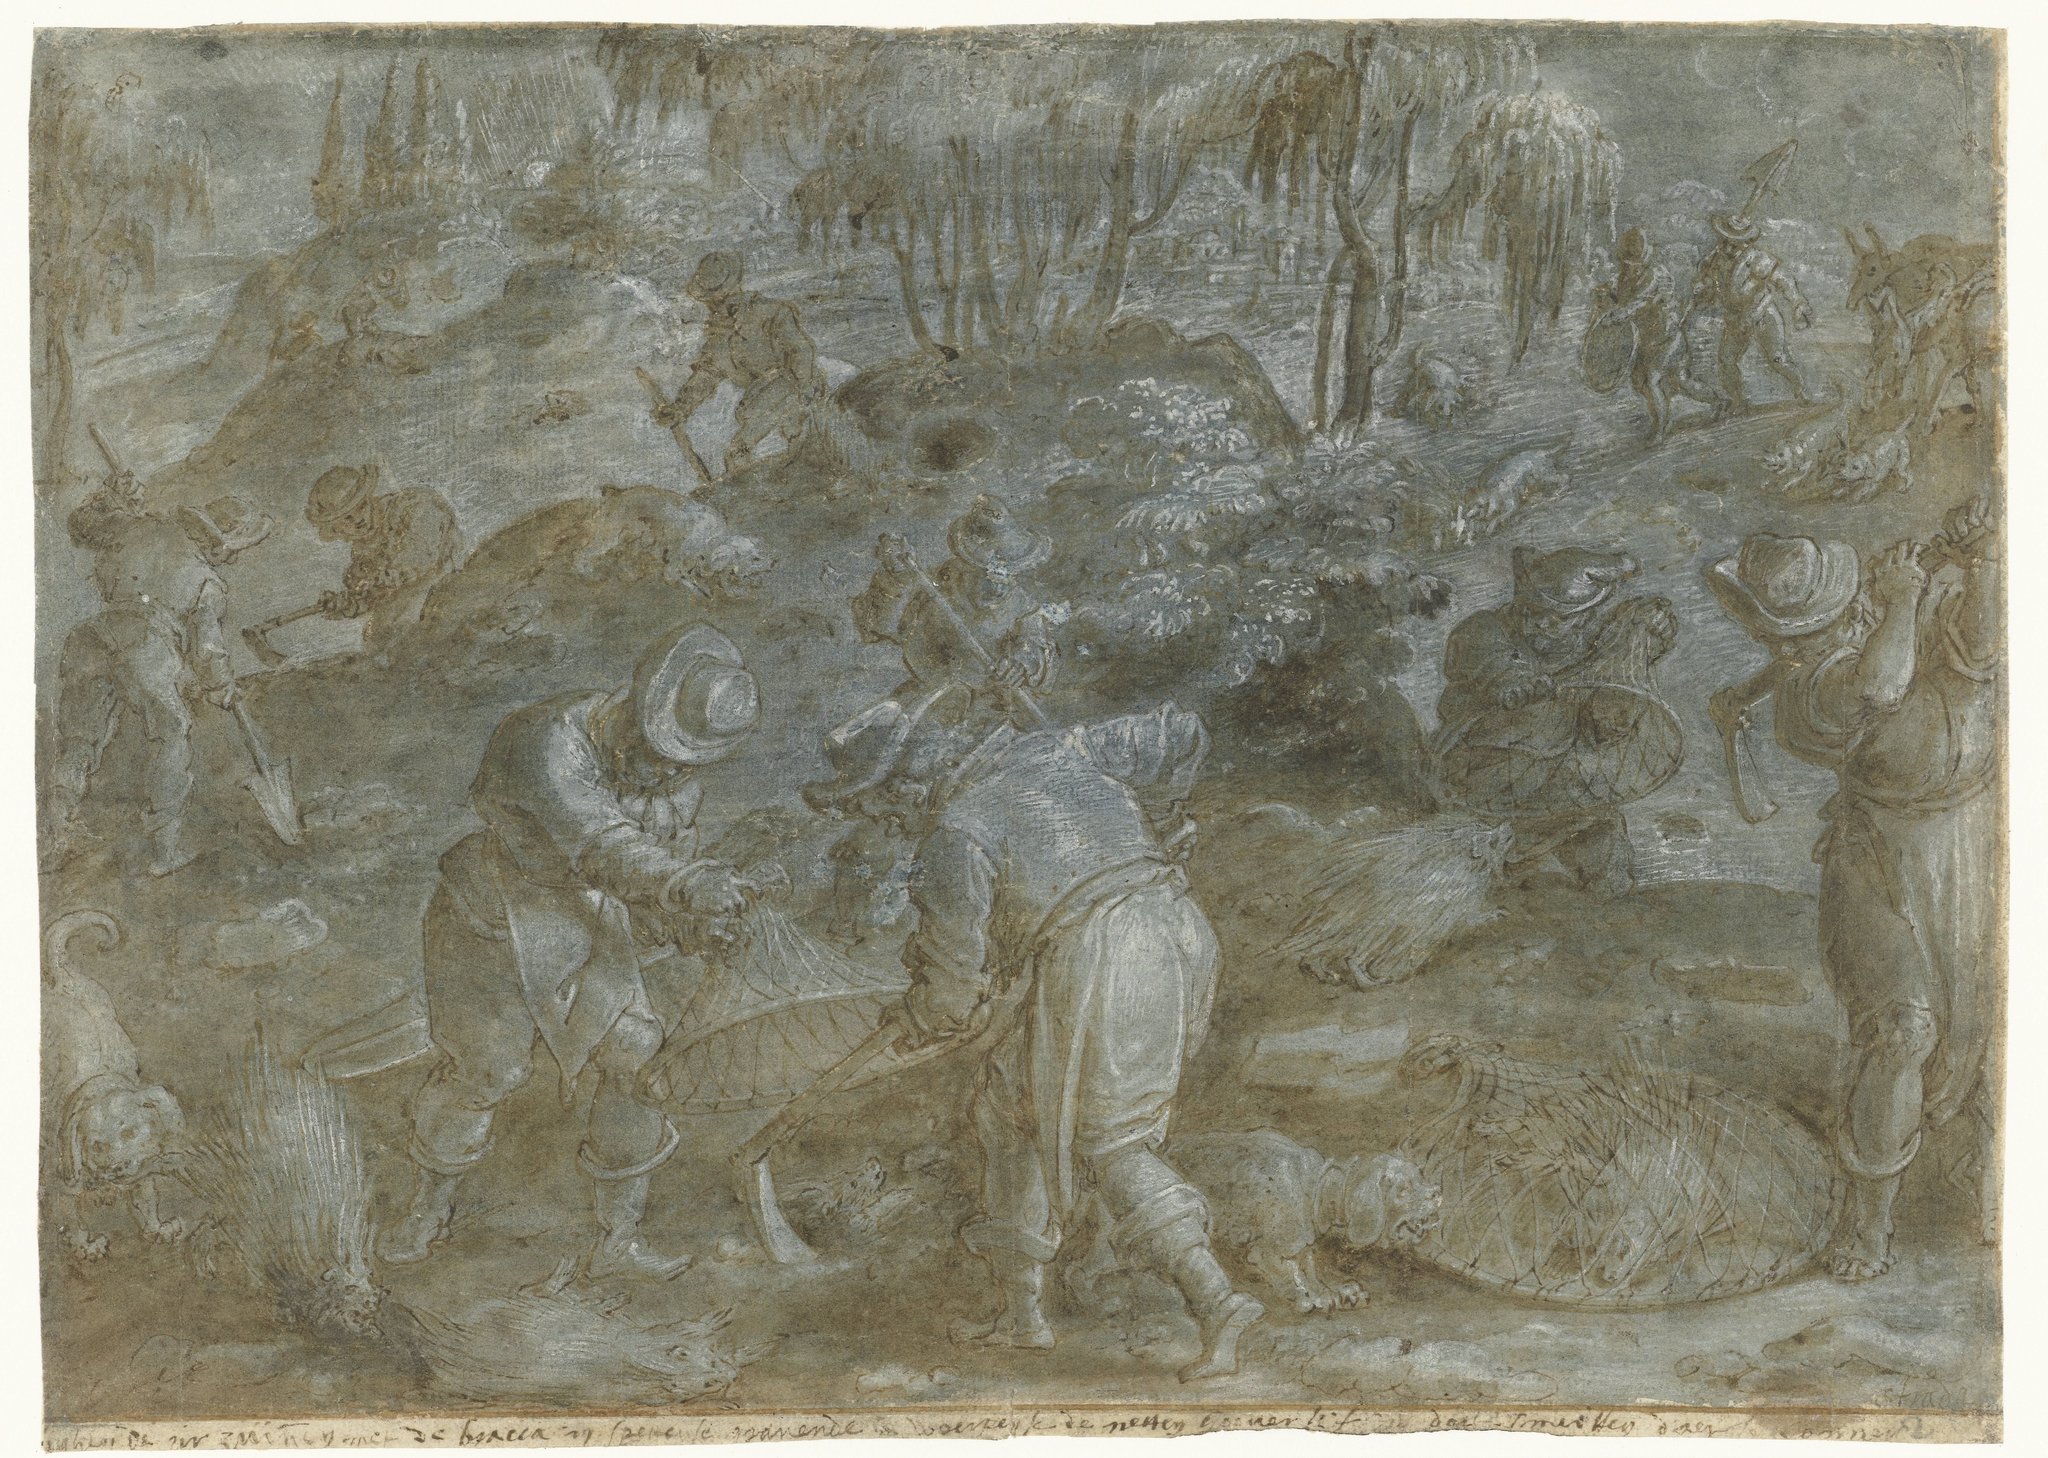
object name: drawing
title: Jacht op stekelvarkens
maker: jan van der straet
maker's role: draughtsman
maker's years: 1523-1605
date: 1533-1578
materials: ink, paint, paper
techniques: brush, pen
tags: hunting, chase, other mammals: porcupine